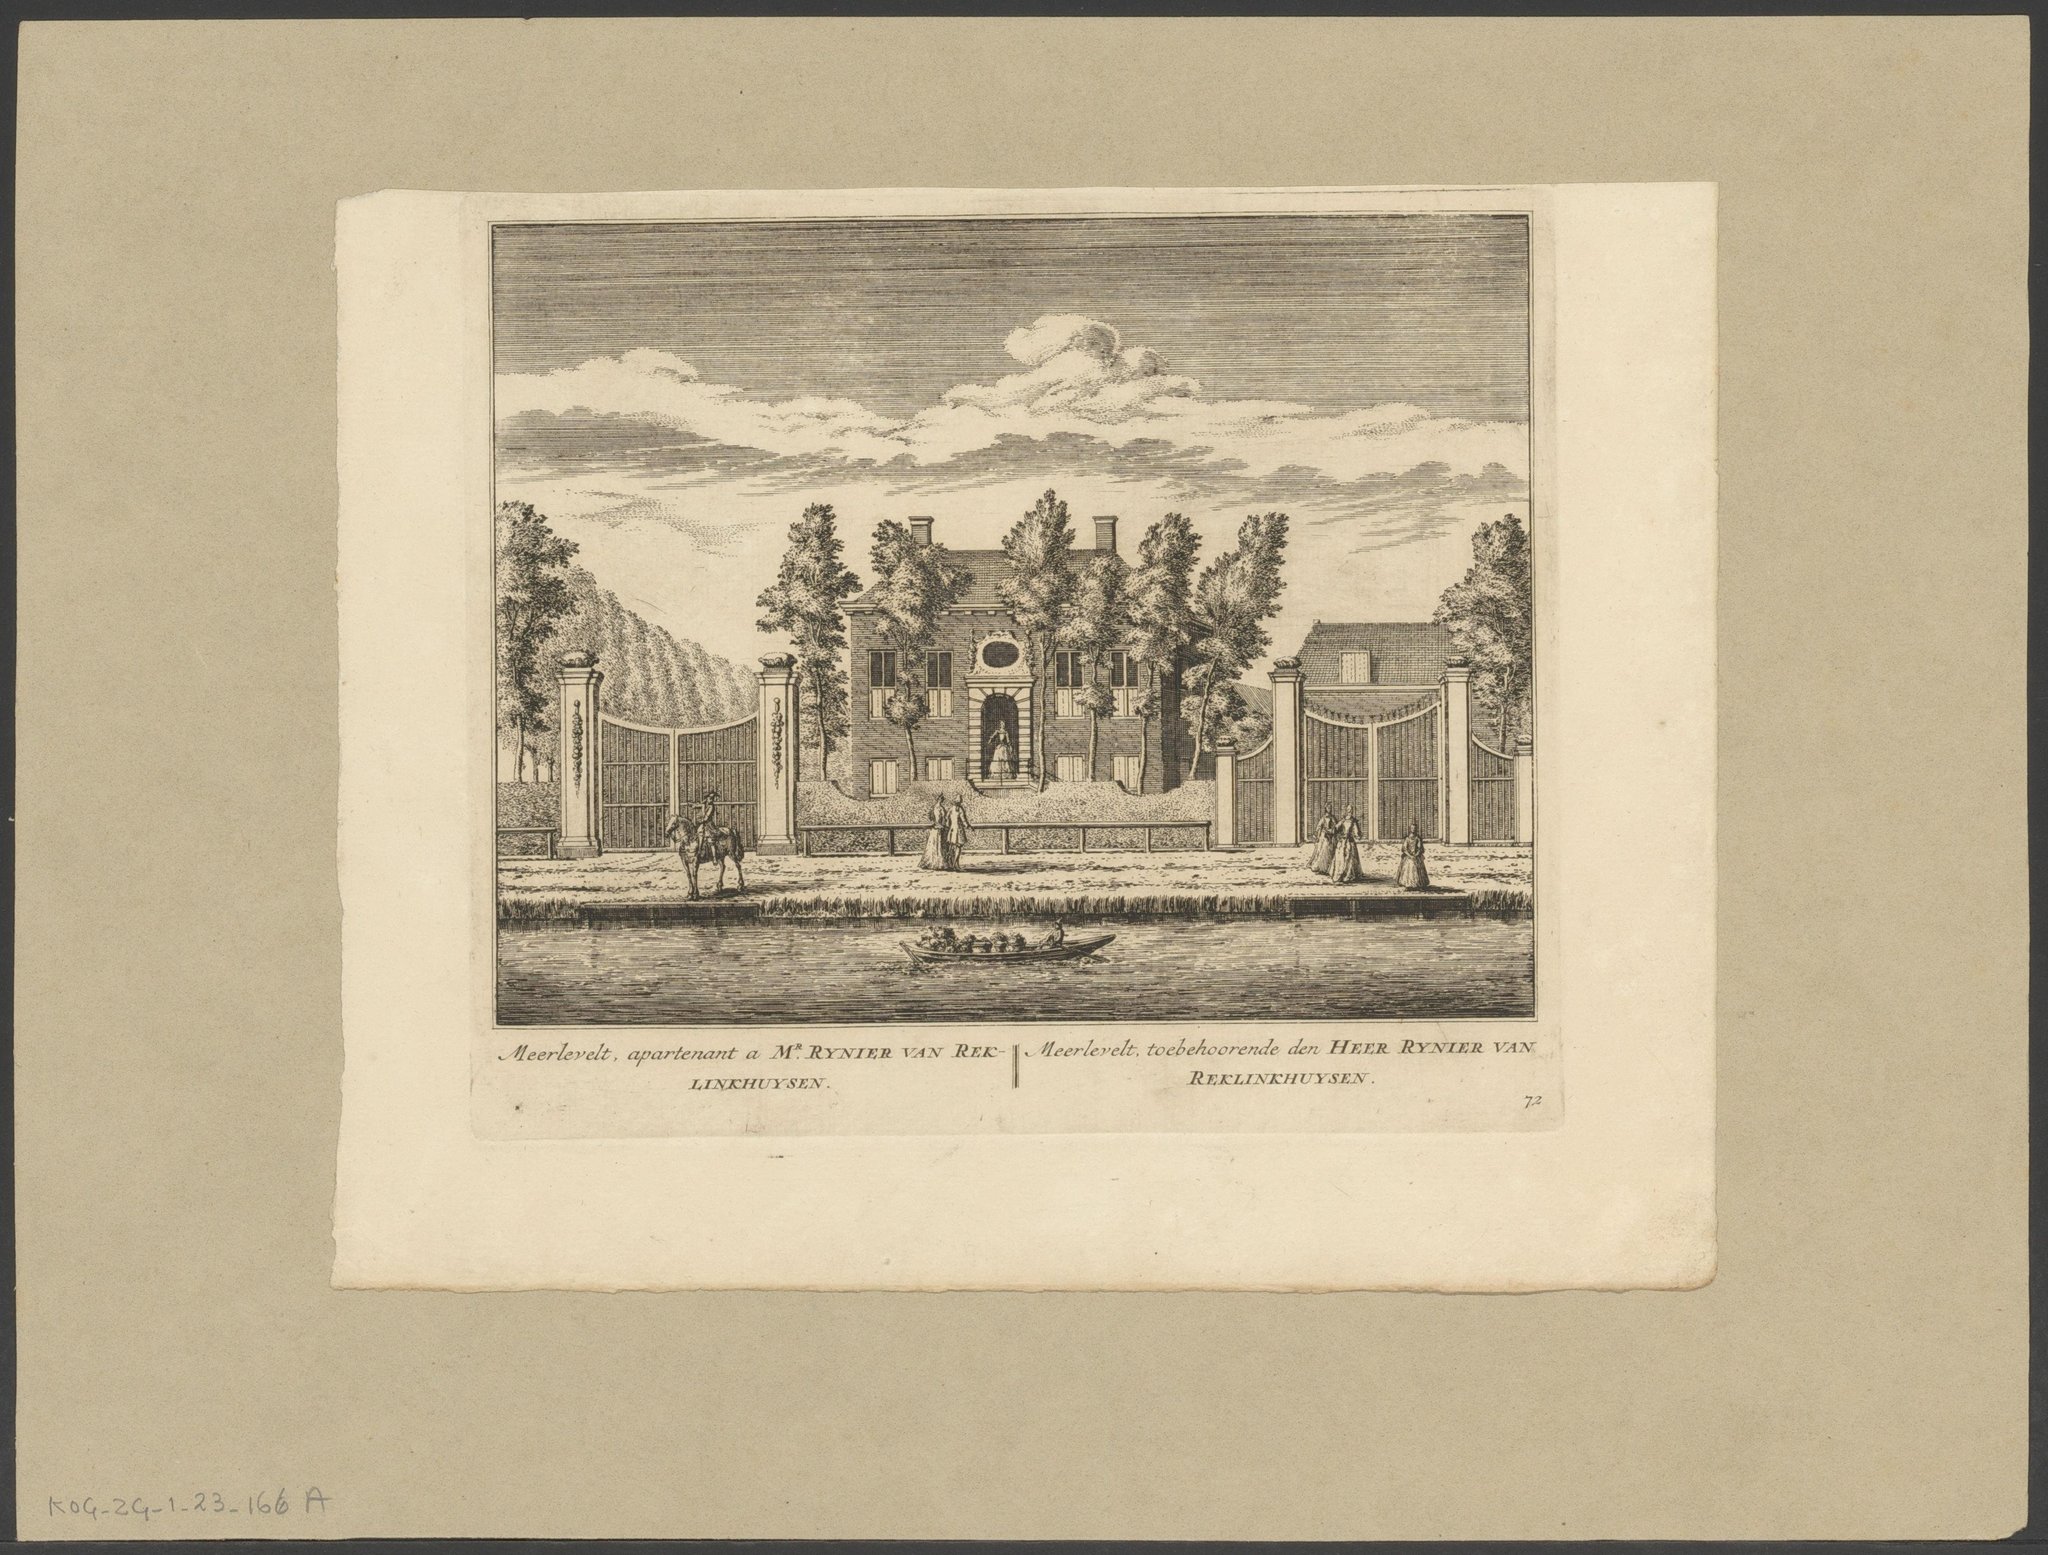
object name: print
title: Gezicht op de buitenplaats Meerleveld, in Baambrugge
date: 1730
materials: paper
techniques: engraving, etching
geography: amsterdam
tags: river, country-house, boat propelled by man or animal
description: Rechtsonder genummerd: 72. Onderwerpsrubrieken binnen de Atlas Zeden en Gewoonten: Zeden en gewoonten in Engeren zin, De woning, Kastelen en buitenplaatsen.